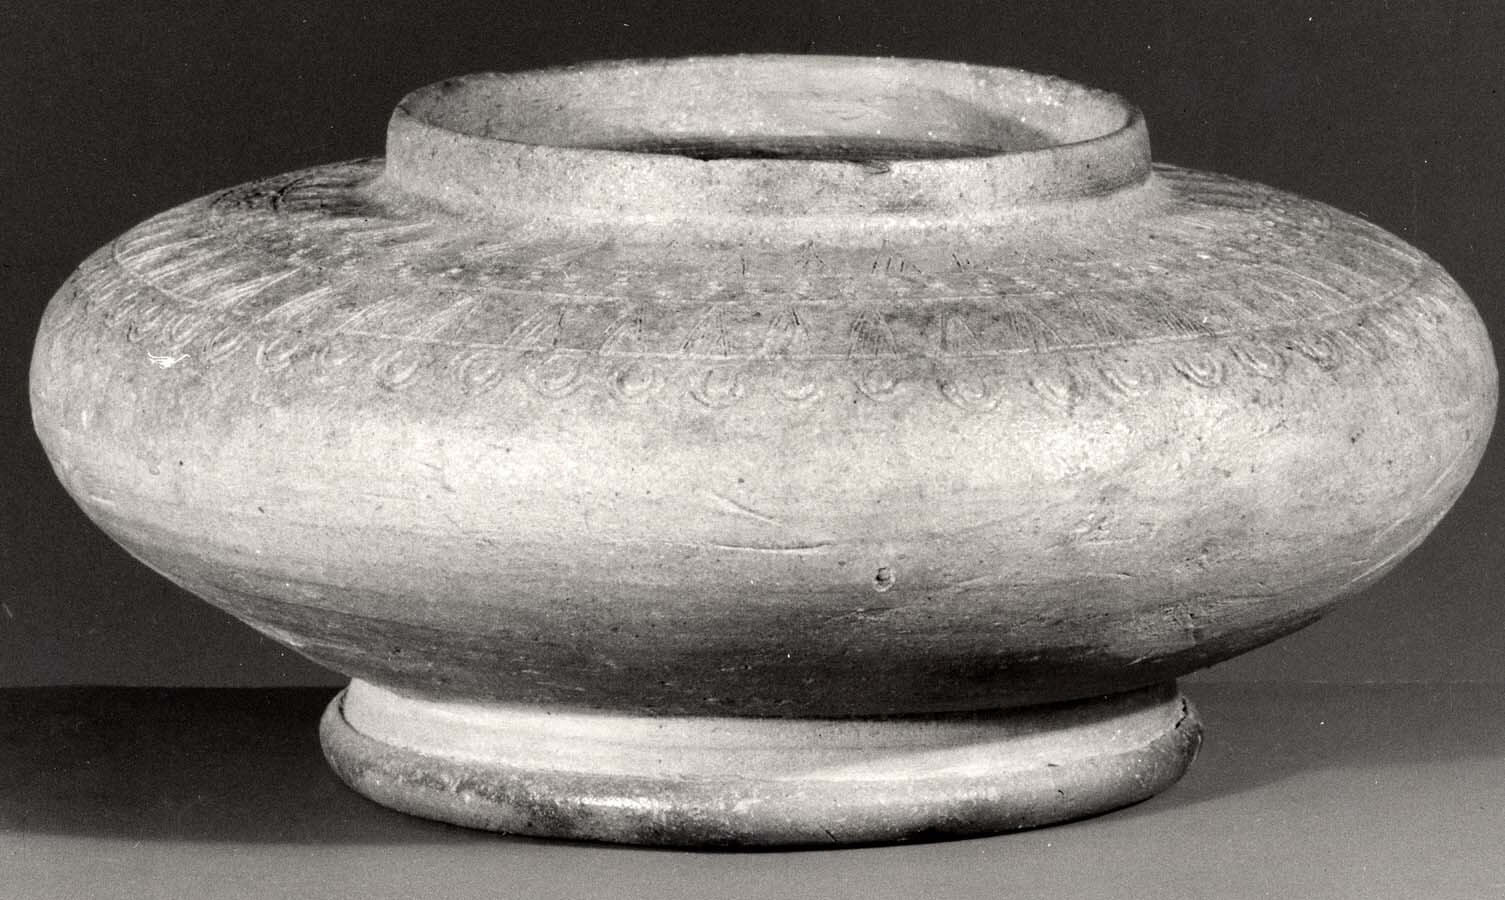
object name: vase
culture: korean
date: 667-700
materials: earthenware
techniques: glazing